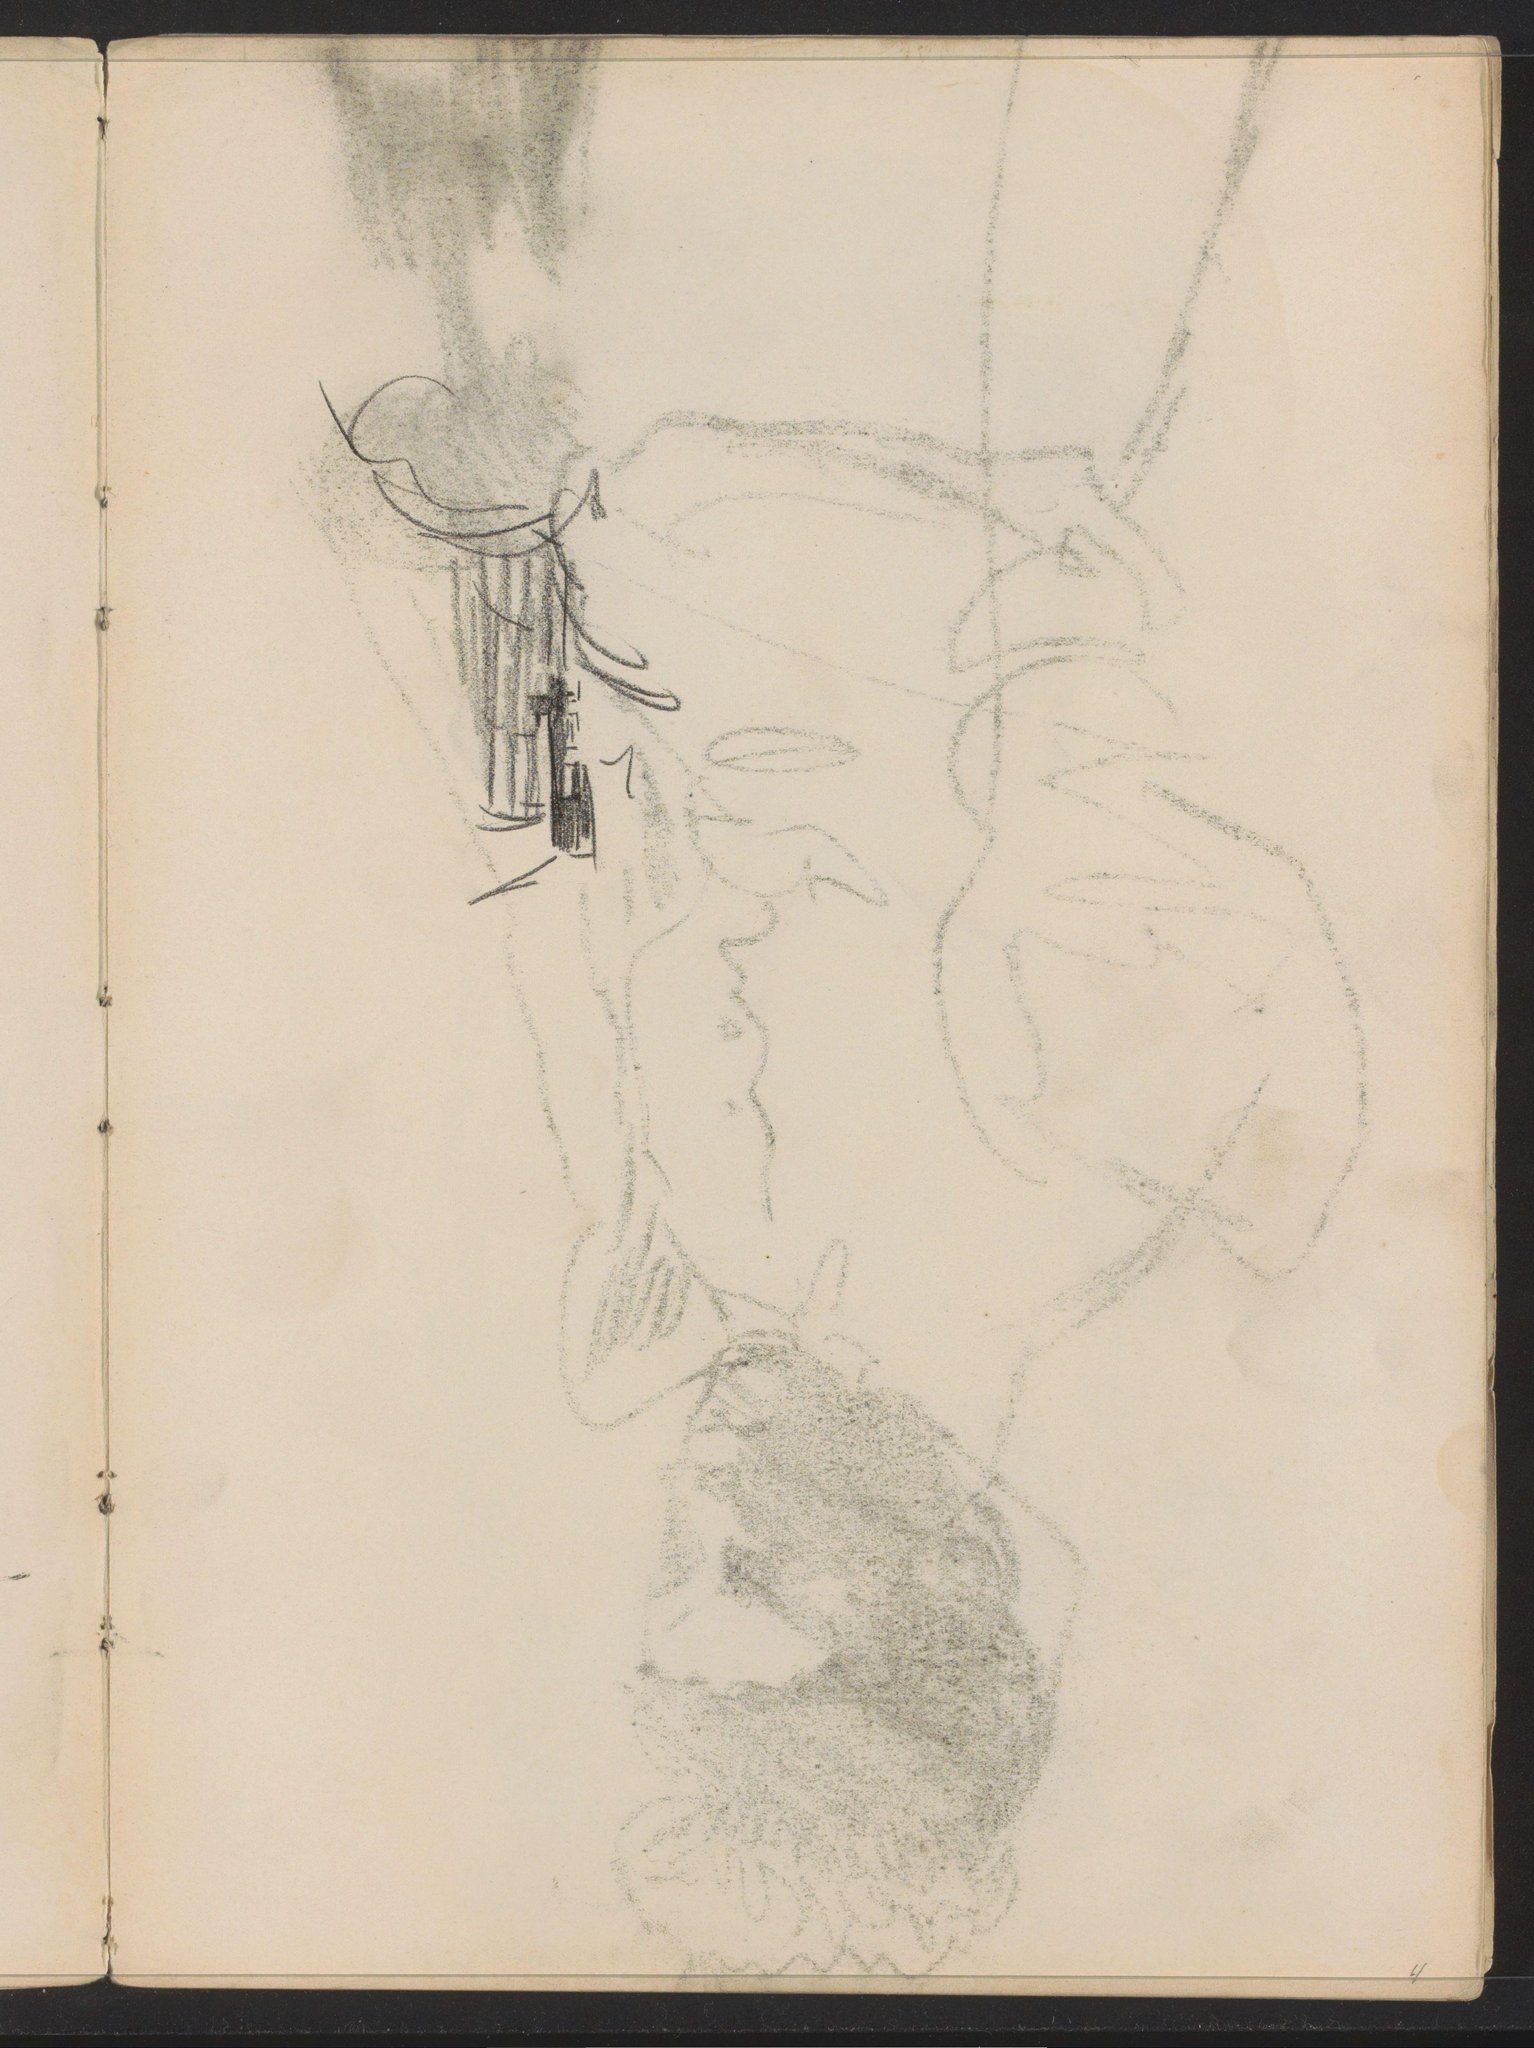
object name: sketchbook leaf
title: Studie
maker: isaac israels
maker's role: draughtsman, painter, print maker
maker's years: 1865-1934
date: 1886-1934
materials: chalk, paper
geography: amsterdam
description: Blad 4 recto uit schetsboek LXVI-B met 25 bladen.